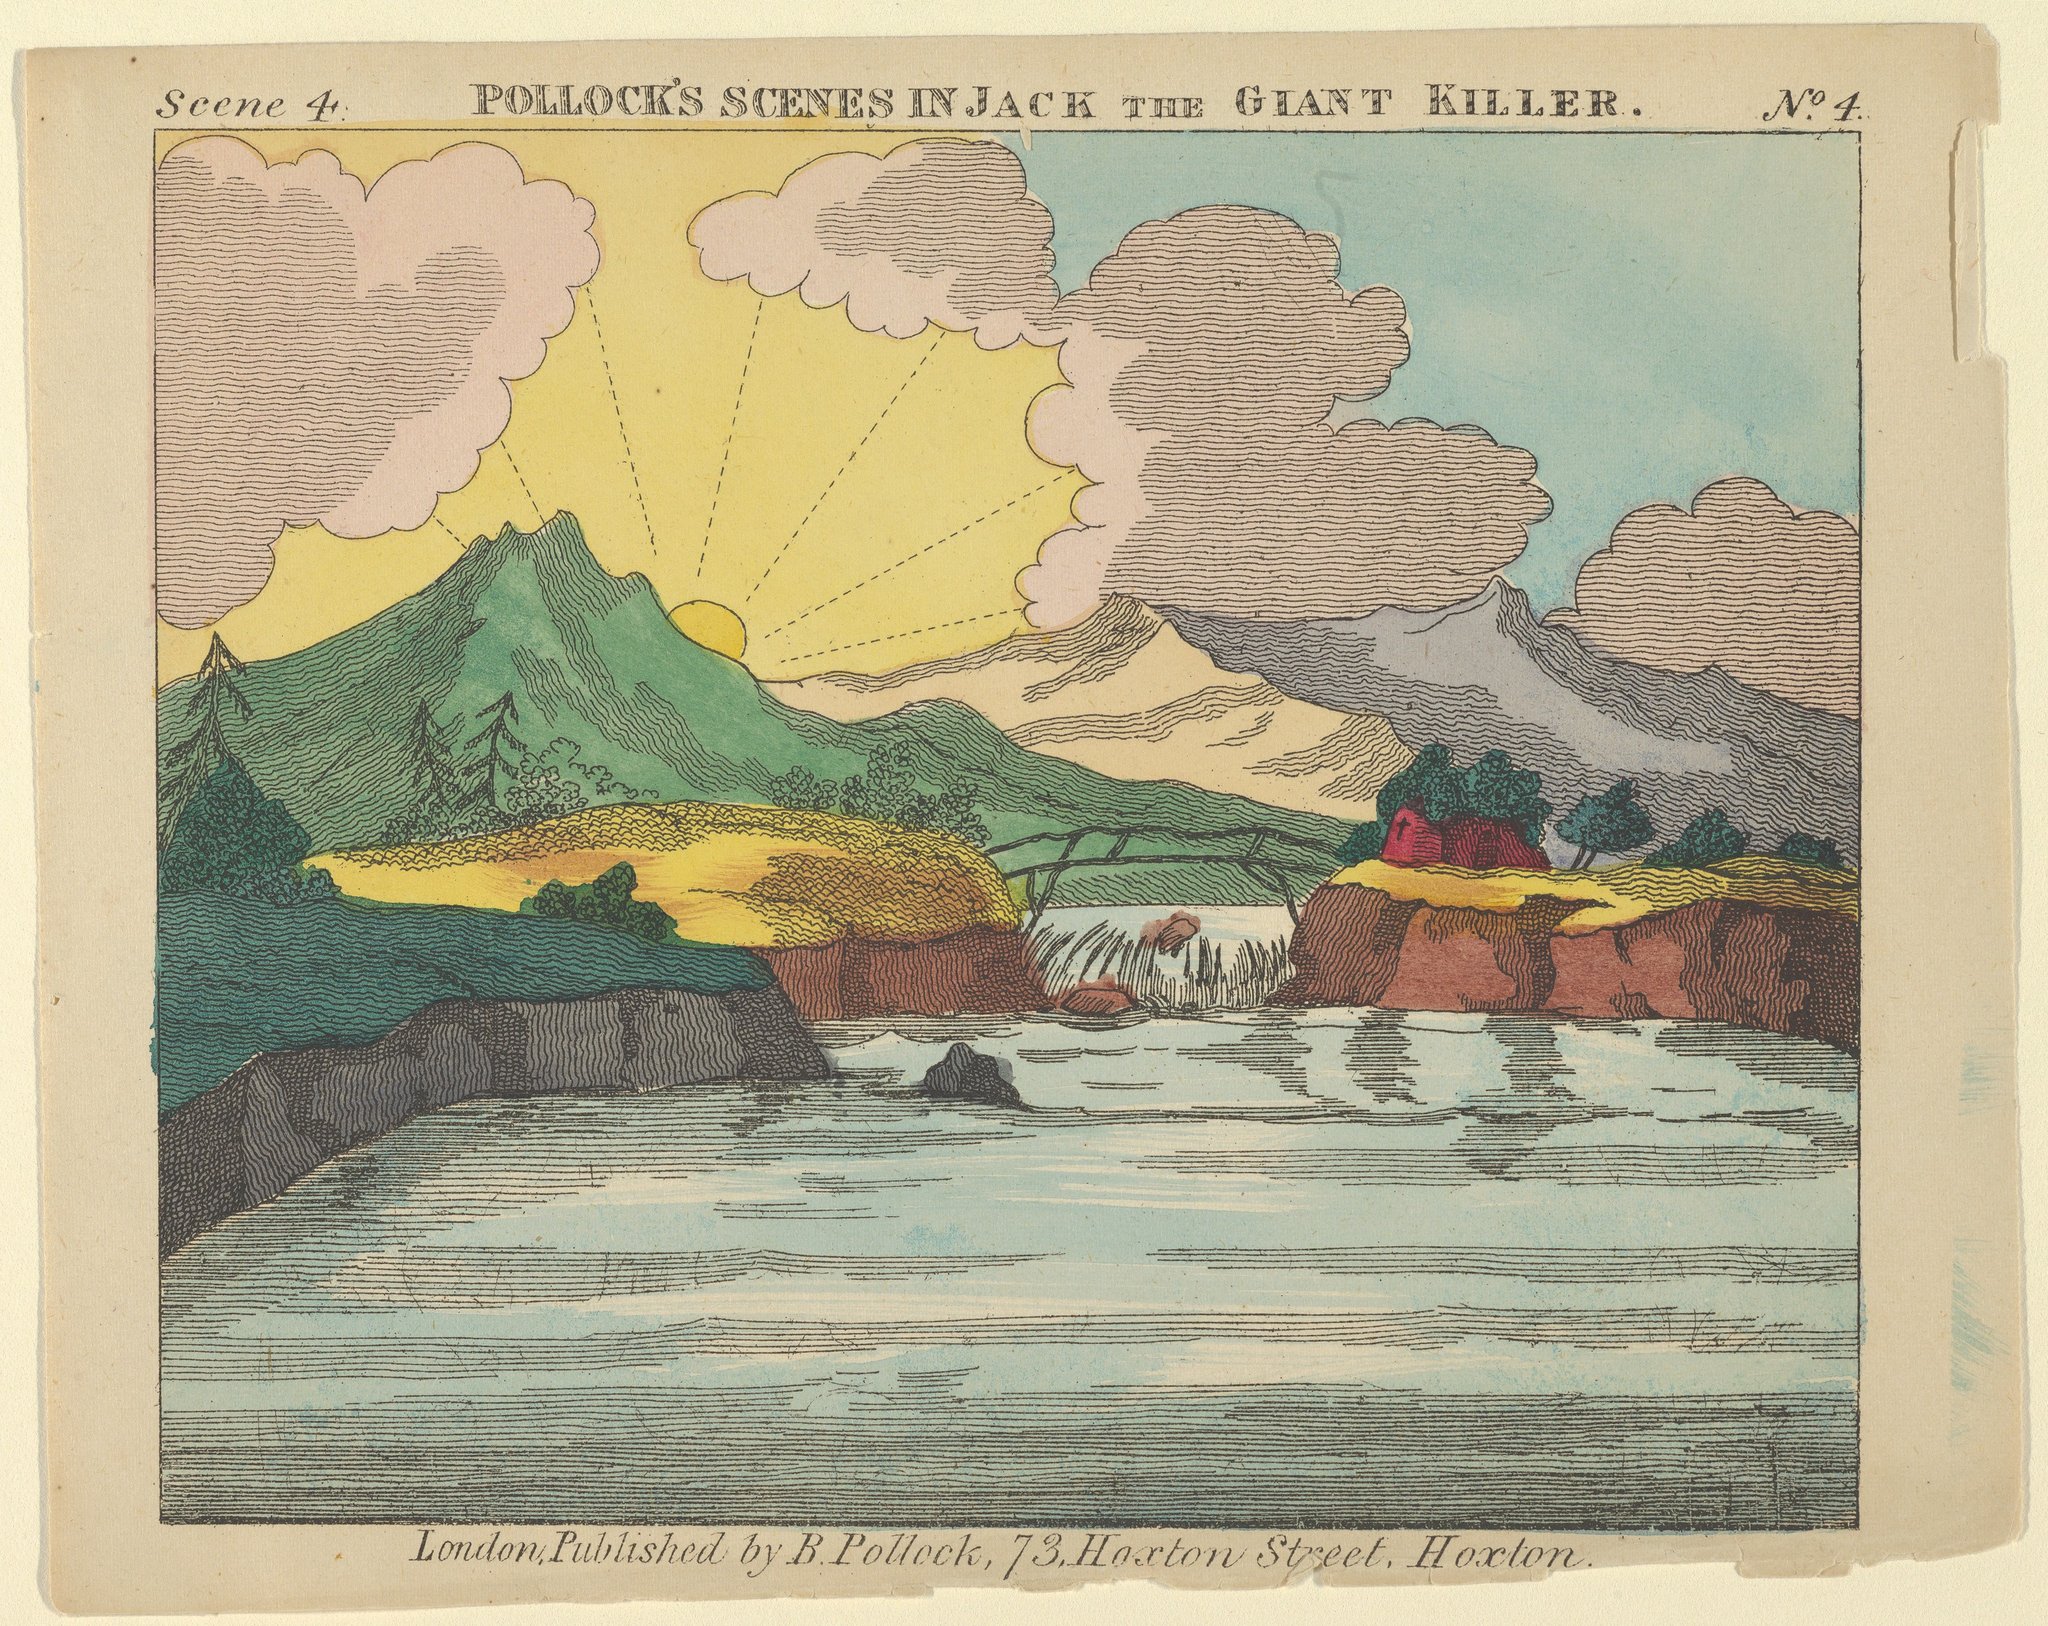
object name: print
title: Scene 4, from Jack and the Giant Killer, Scenes for a Toy Theater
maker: benjamin pollock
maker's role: publisher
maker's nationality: british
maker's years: 1857-1937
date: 1870-1890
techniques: lithograph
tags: sun,hills,landscapes